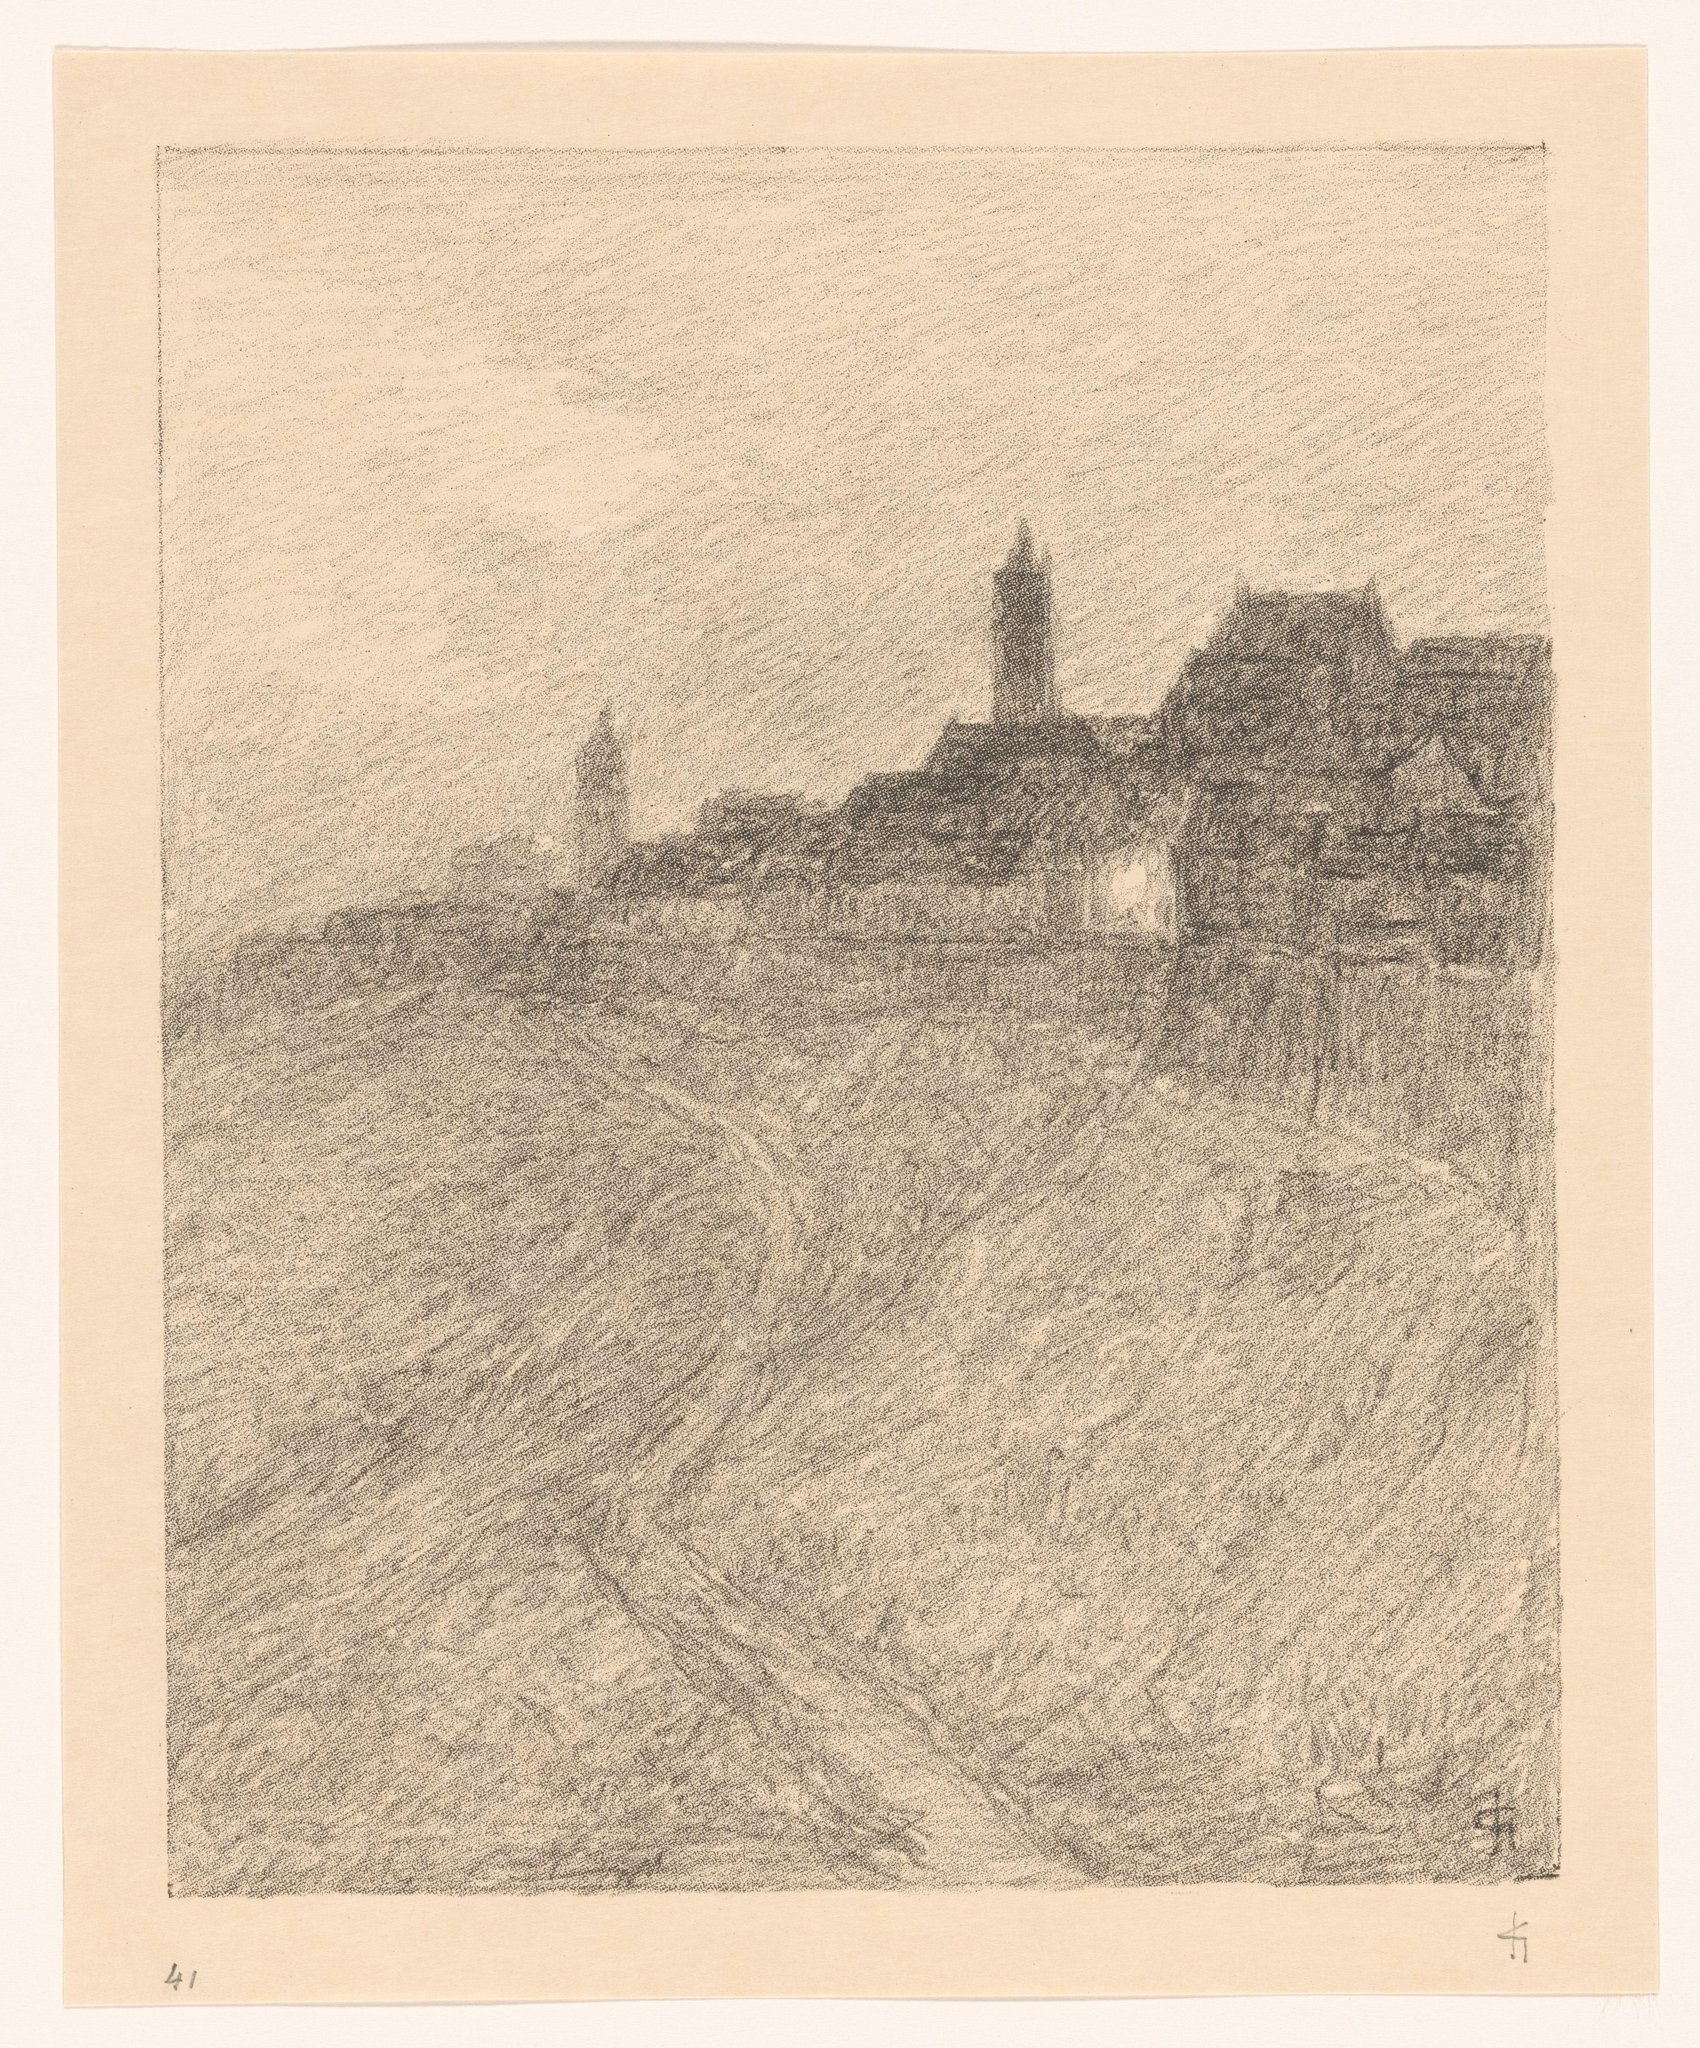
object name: print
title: Gezicht op Rothenburg ob der Tauber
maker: carel nicolaas storm van s-gravesande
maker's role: draughtsman, print maker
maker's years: 1841-1924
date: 1851-1902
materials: paper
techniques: lithograph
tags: prospect of city, town panorama, silhouette of city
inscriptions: collector's mark: Lugt 2228, number: ‘41’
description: Mogelijk vermeld in: Storm van 's-Gravesande, Charles. Catalogue des eaux-fortes et lithographies. New York: s.n., 1903, of in een onbekende latere uitgave van het manuscript. Vermoedelijk vermeld als catalogusnummer 41.